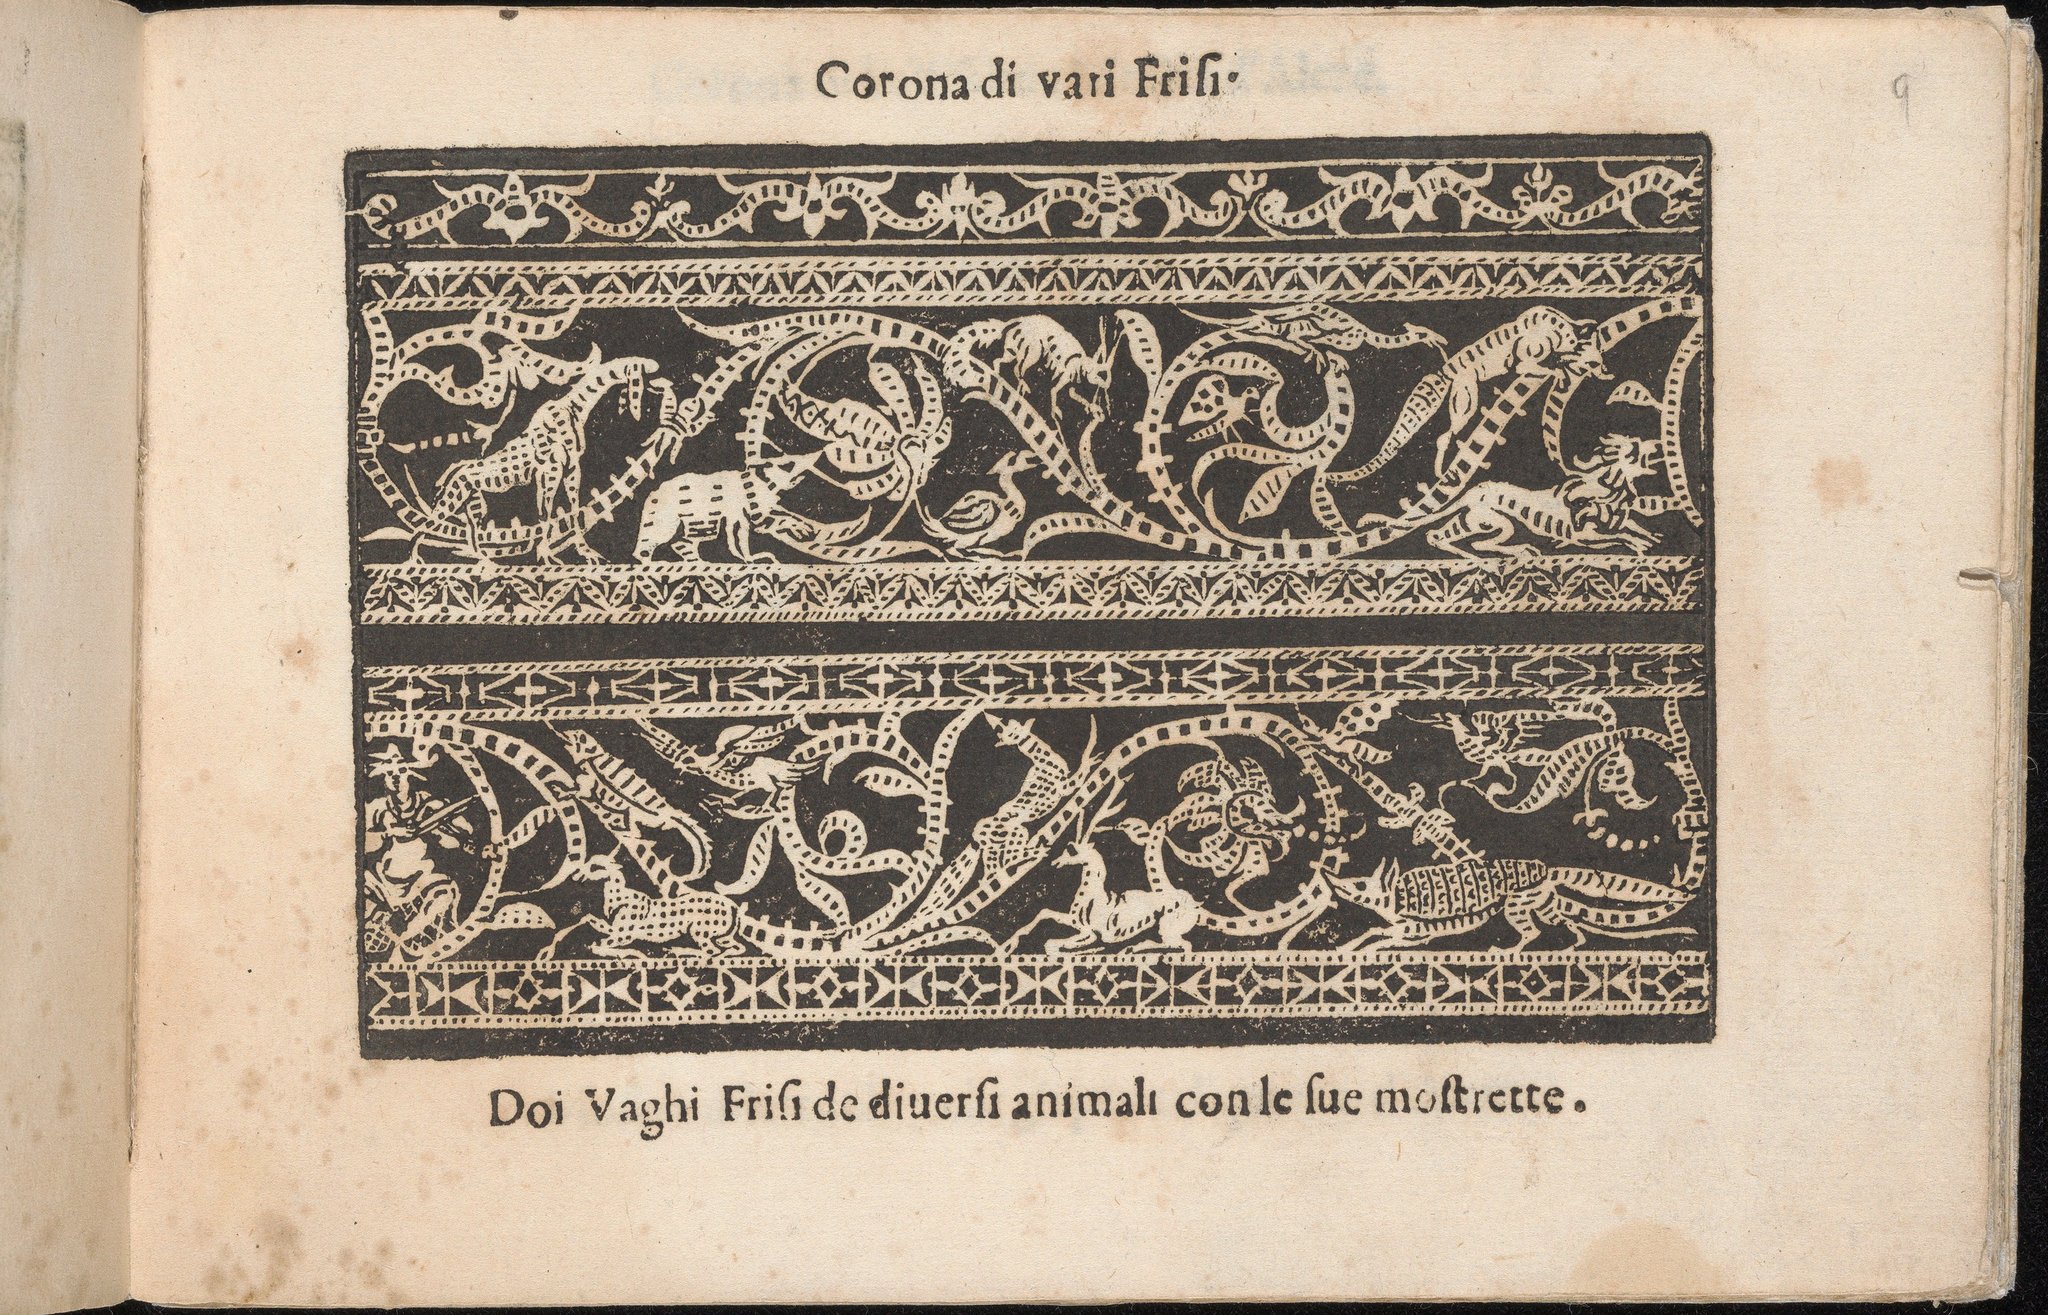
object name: book print ornament architecture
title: Corona delle Nobile et Virtuose Donne, Libro Terzo, page 9 (recto)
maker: cesare vecellio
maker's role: designer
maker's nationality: italian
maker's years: 1521-1601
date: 1620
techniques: woodcut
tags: birds,foxes,squirrels,flowers,leaves